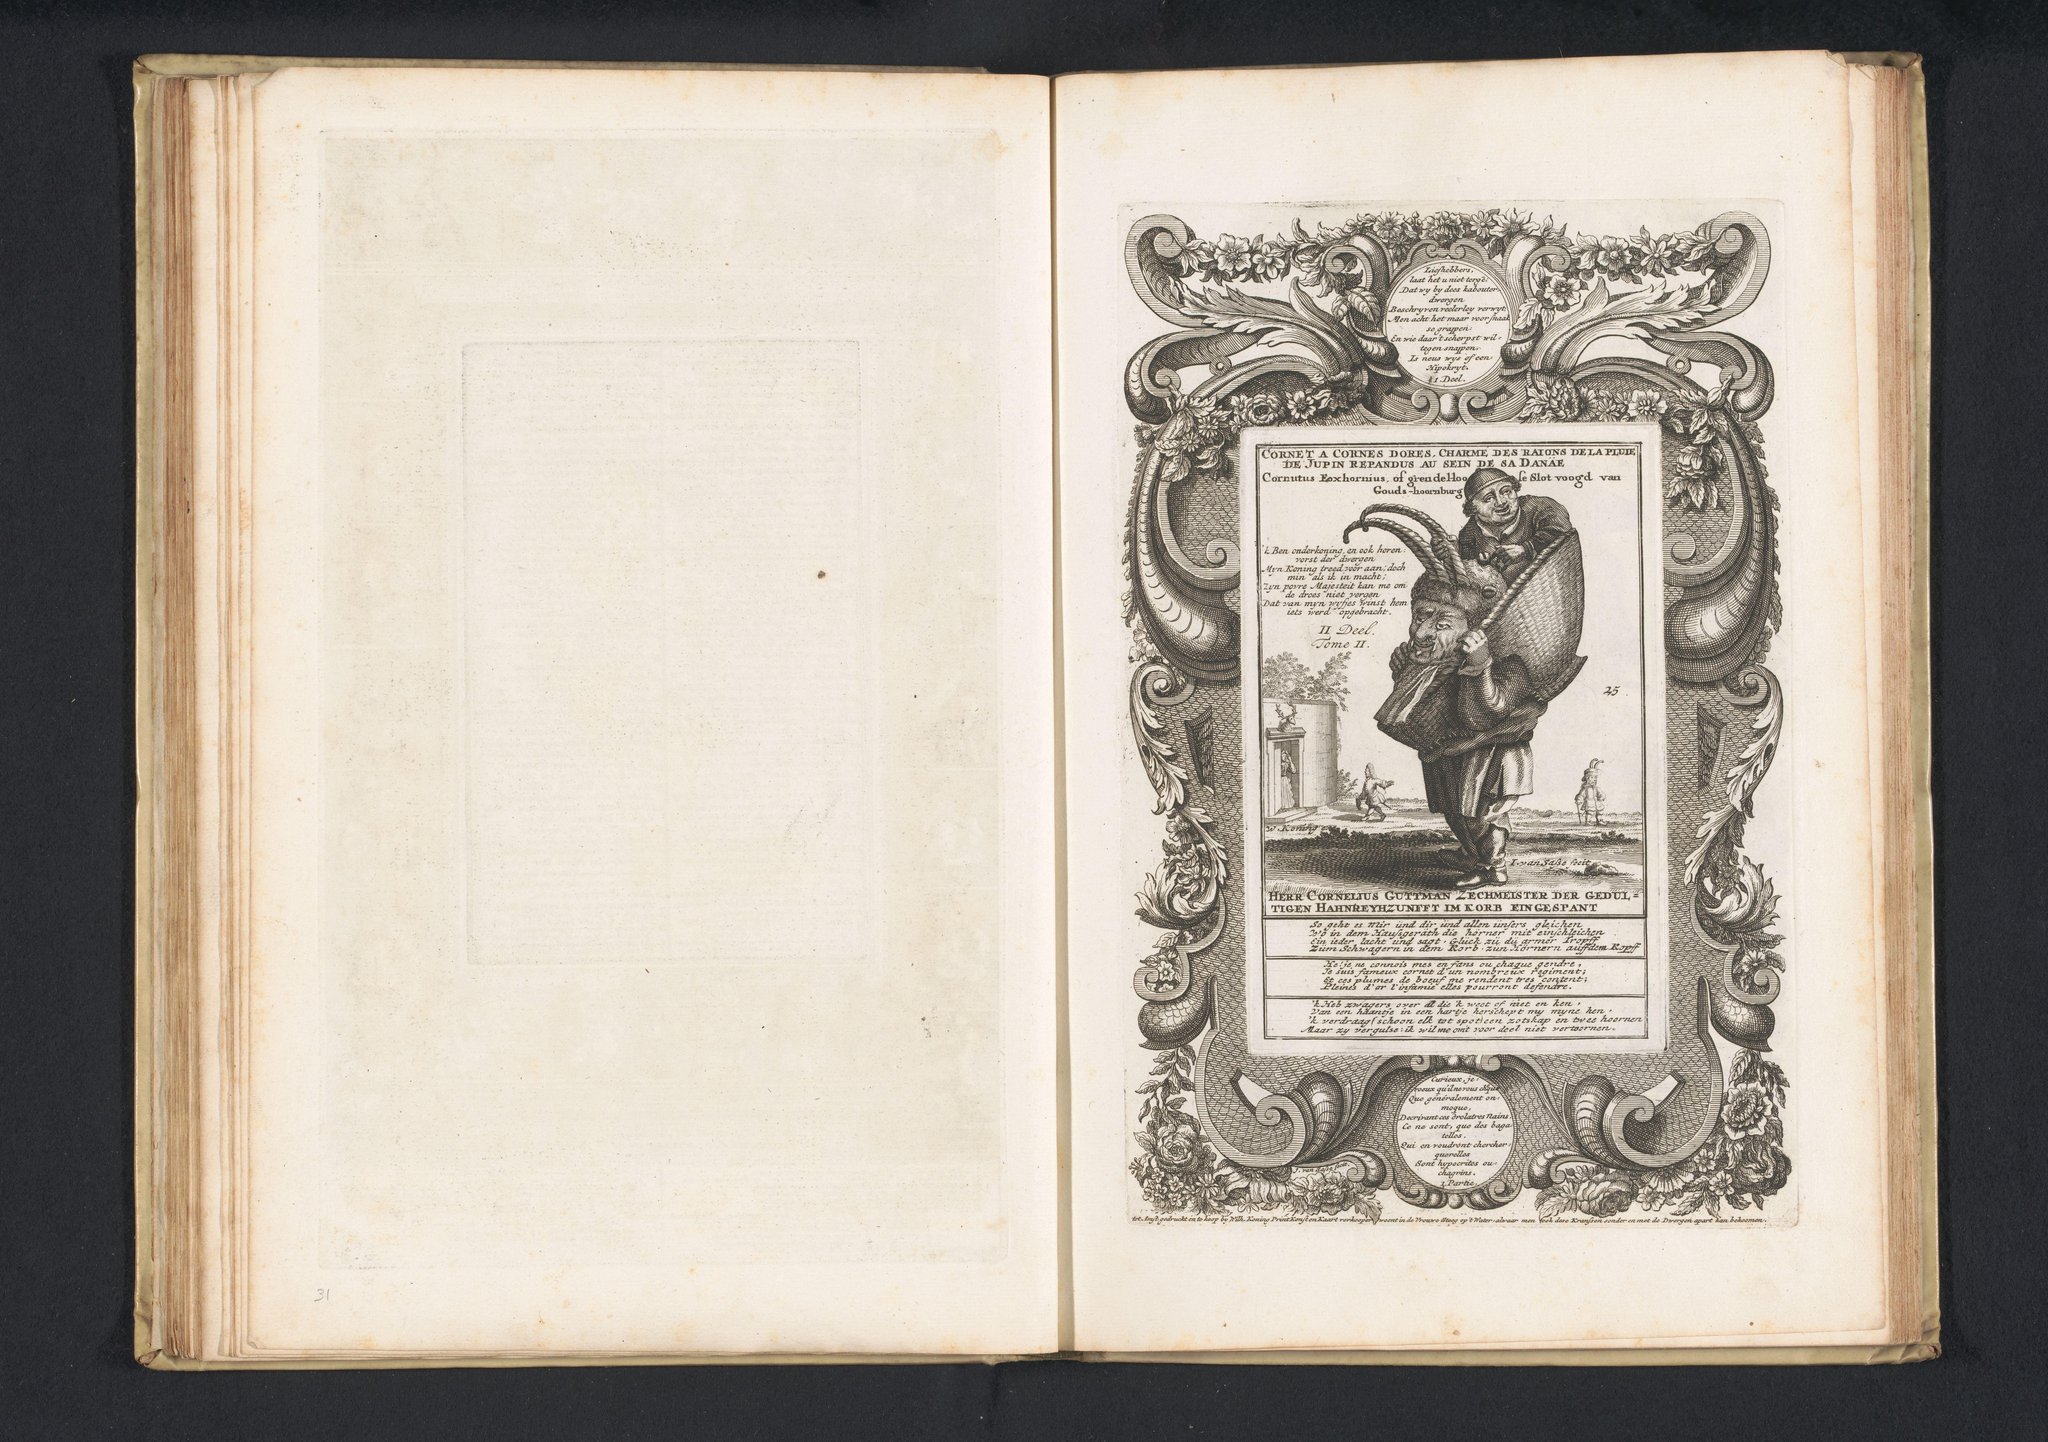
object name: print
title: Bombario Actionist en de Geest van Esopus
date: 1716-1720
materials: paper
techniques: etching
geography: northern netherlands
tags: partner deceived, caricatures (human types), little people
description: De kleine mens Cornutus Foxhornius als hoorndrager, de bedrogen echtgenoot, op zijn schouders een mand waarin een man zit. In het onderschrift verzen in het Duits, Frans en Nederlands. Genummerd: II Deel 25. Afdruk binnen een decoratieve omlijsting gedrukt van een aparte plaat met rocailles en bloemen. Onderdeel van deel II in de tweede Nederlandse gebonden uitgave uit 1720 (en gerelateerd aan de Windhandel in dat jaar) van een serie karikaturen van kleine mensen, bekend als Het Dwergentooneel, deels gekopieerd naar een ouder Duits voorbeeld.